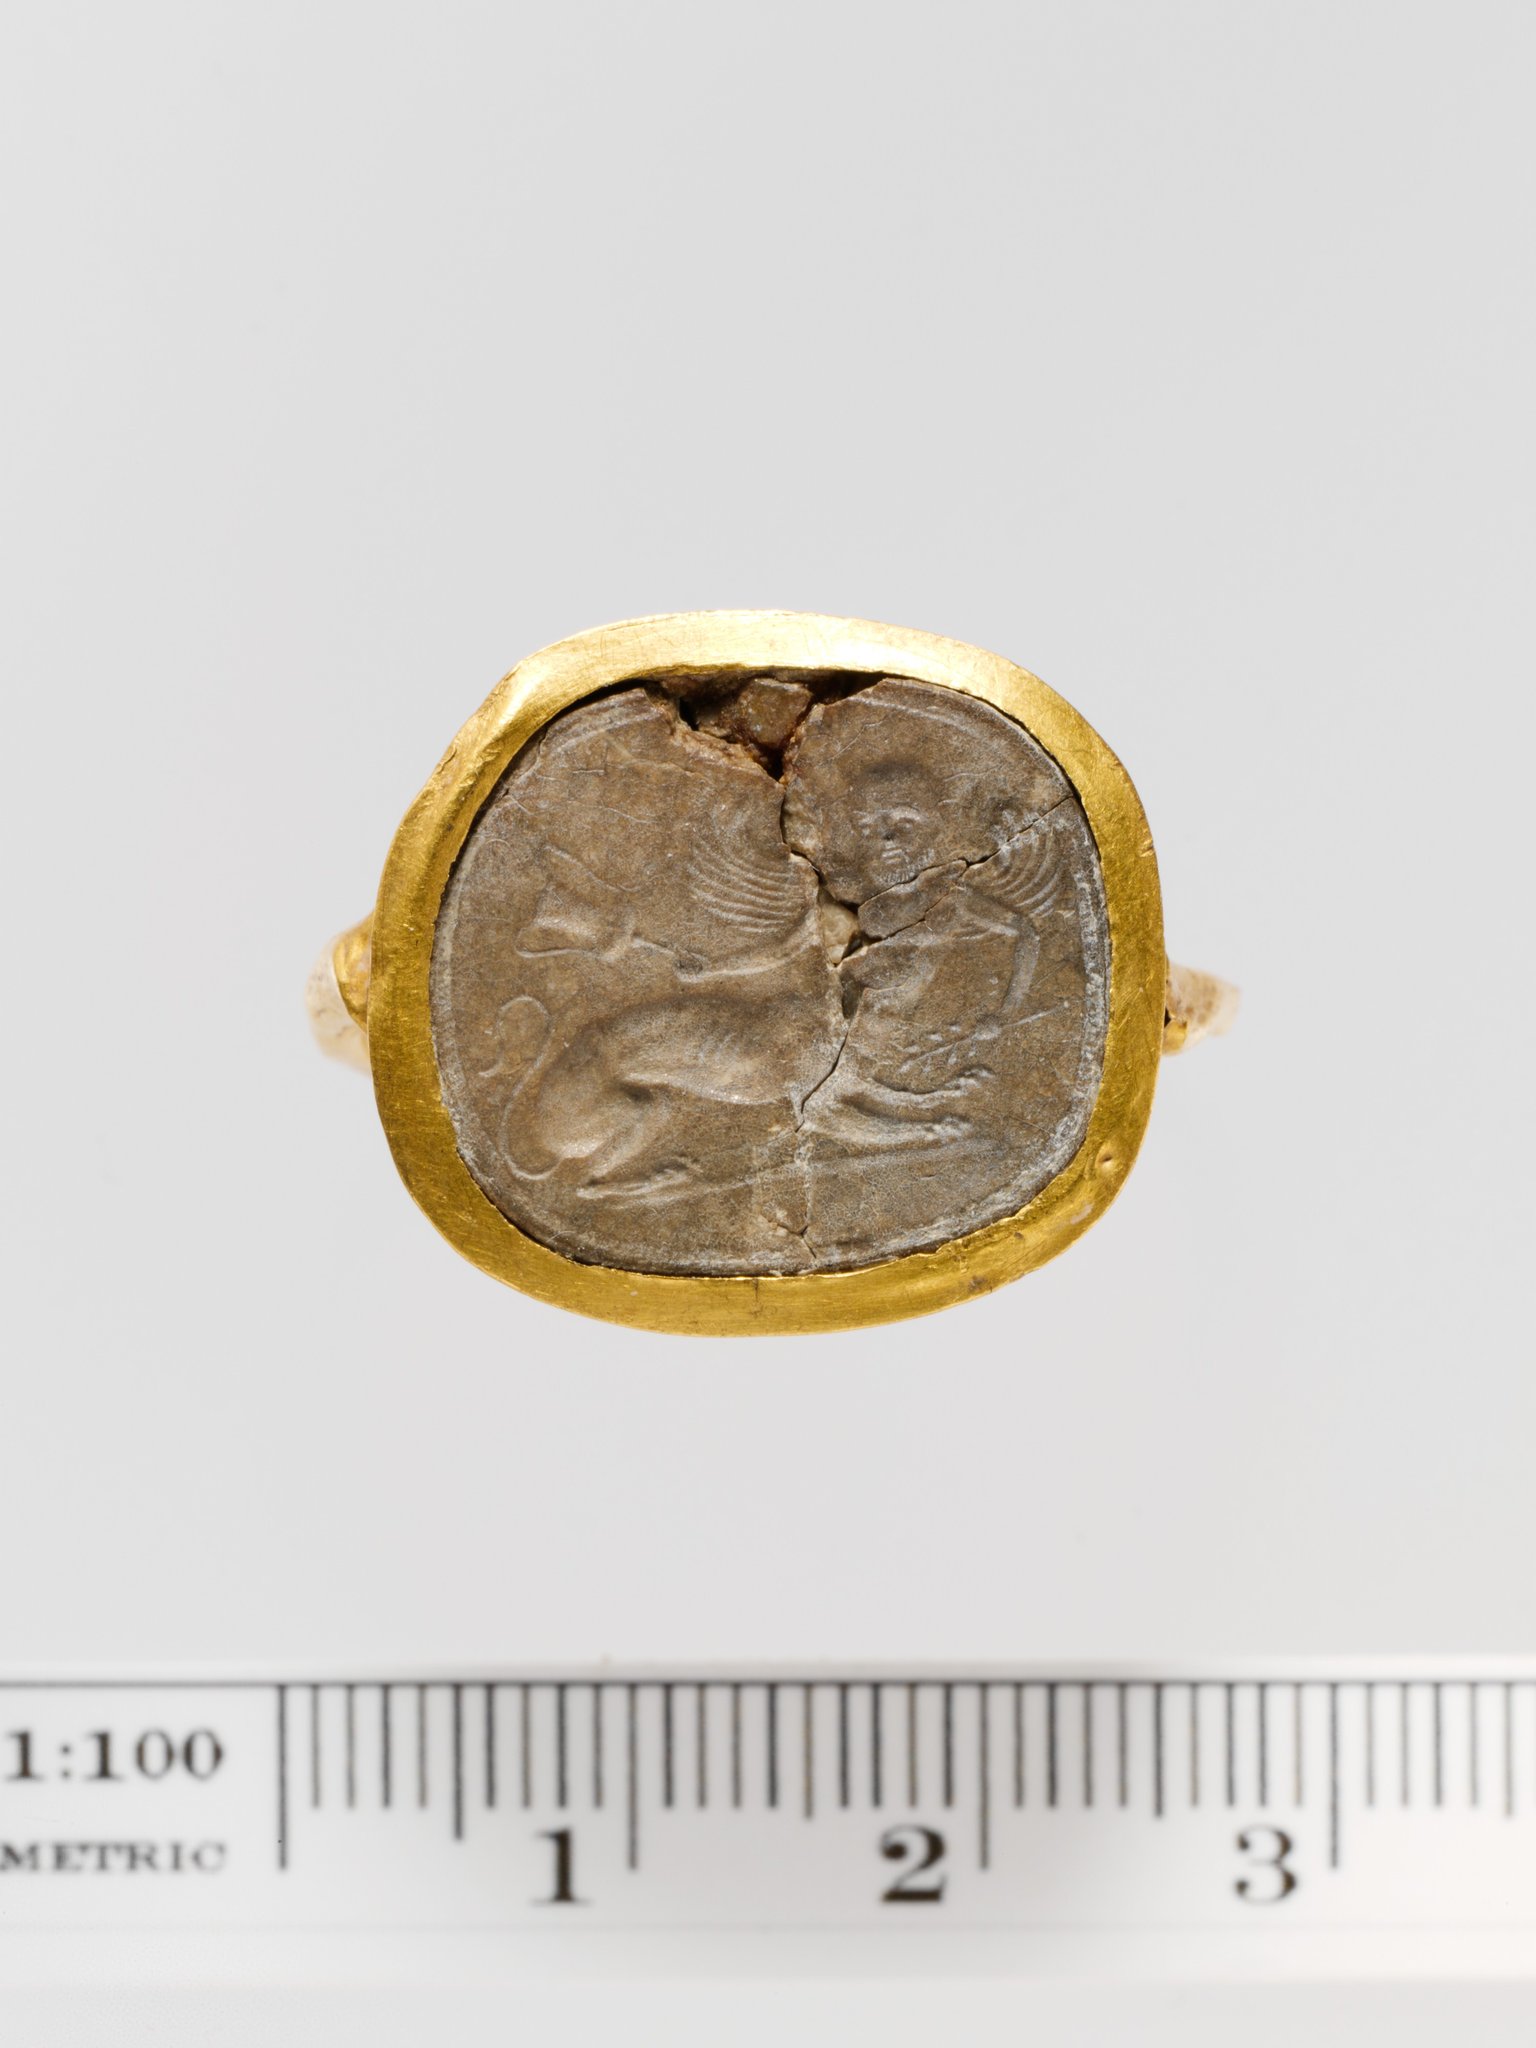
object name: ring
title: Chalcedonic quartz seal set in a gold ring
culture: greek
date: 400-301 BCE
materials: gold, paste, quartz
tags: satyrs,lions,demons